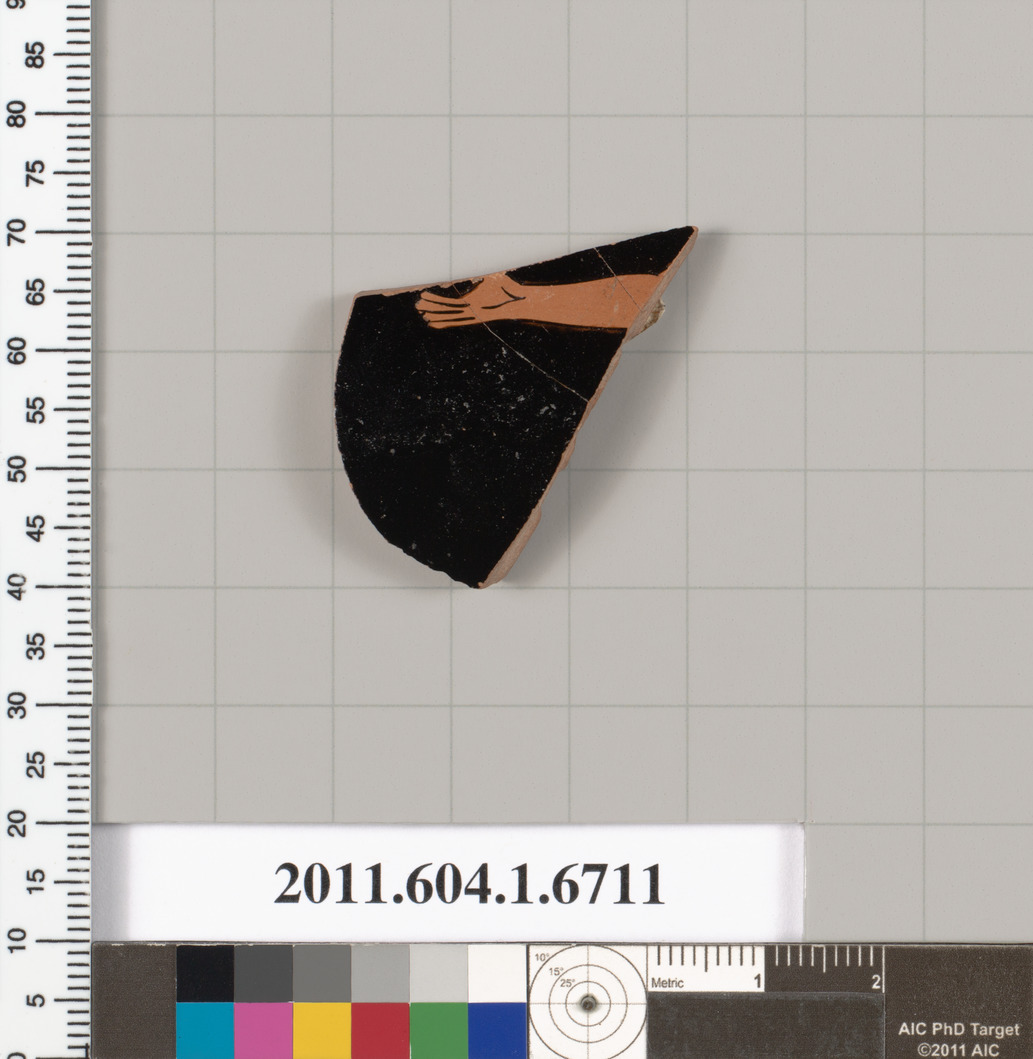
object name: kylix fragment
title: Terracotta fragment of a kylix (drinking cup)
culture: greek, attic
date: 490-470 BCE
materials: terracotta